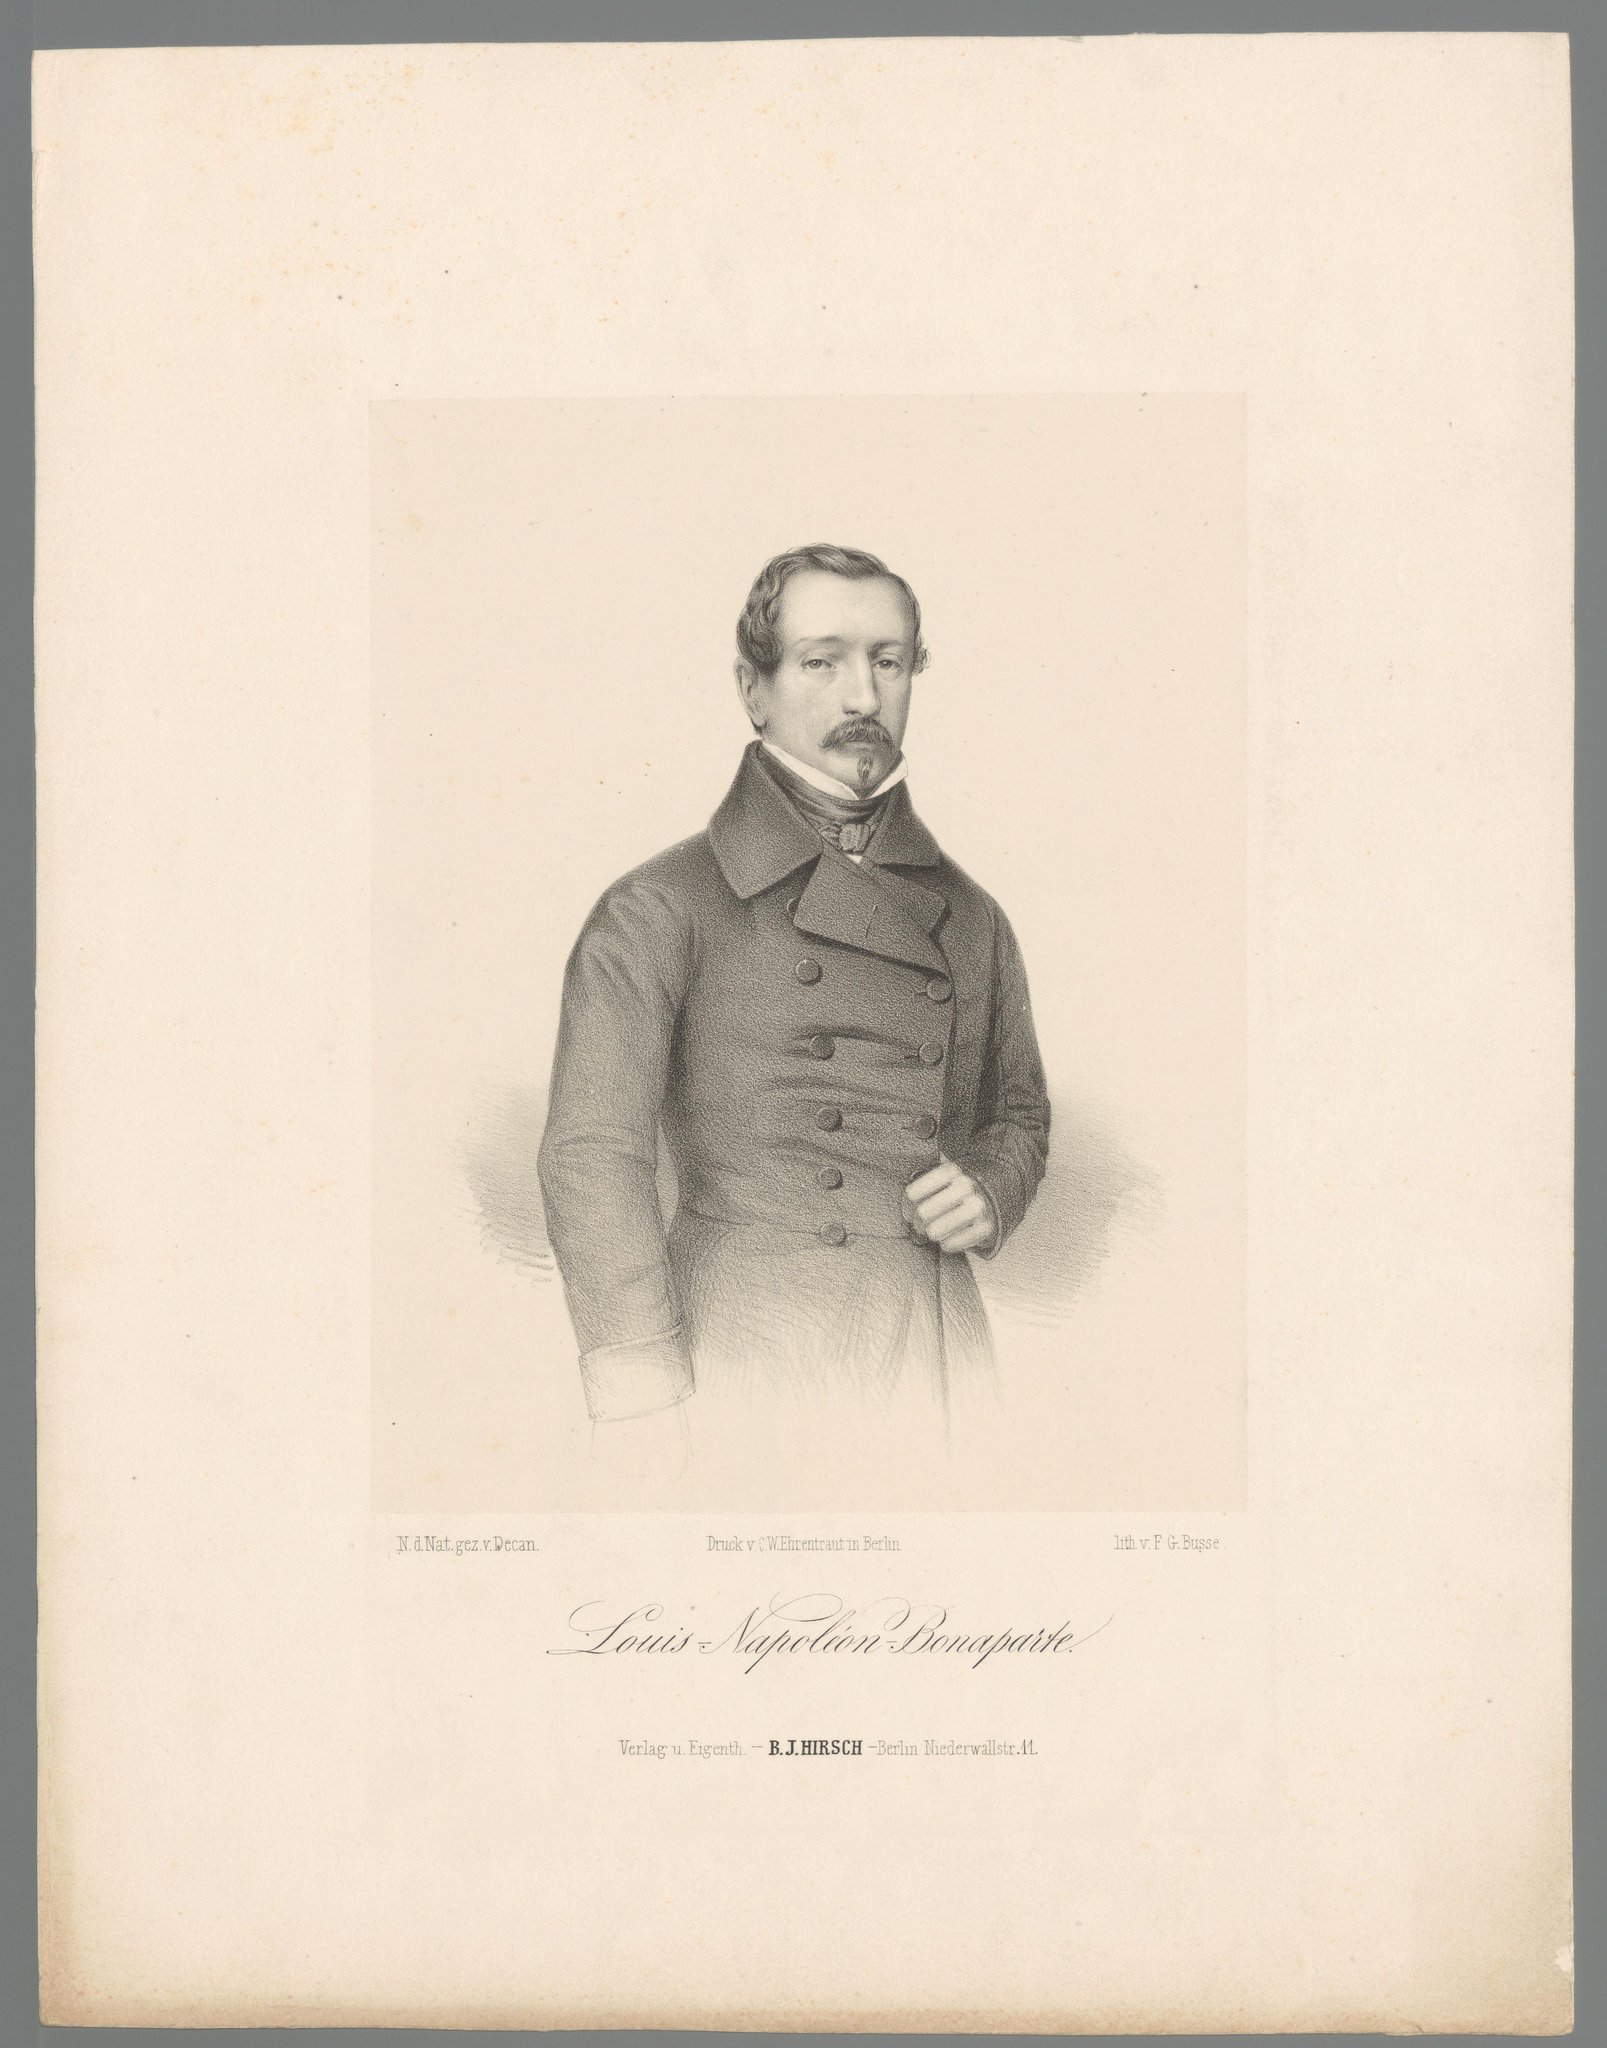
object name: print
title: Portret van Napoleon Bonaparte III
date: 1870-1875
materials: paper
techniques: lithograph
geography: berlin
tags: paris, london, napoleon iii (keizer der fransen), adult man, historical persons, beard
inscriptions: collector's mark: Lugt 2228